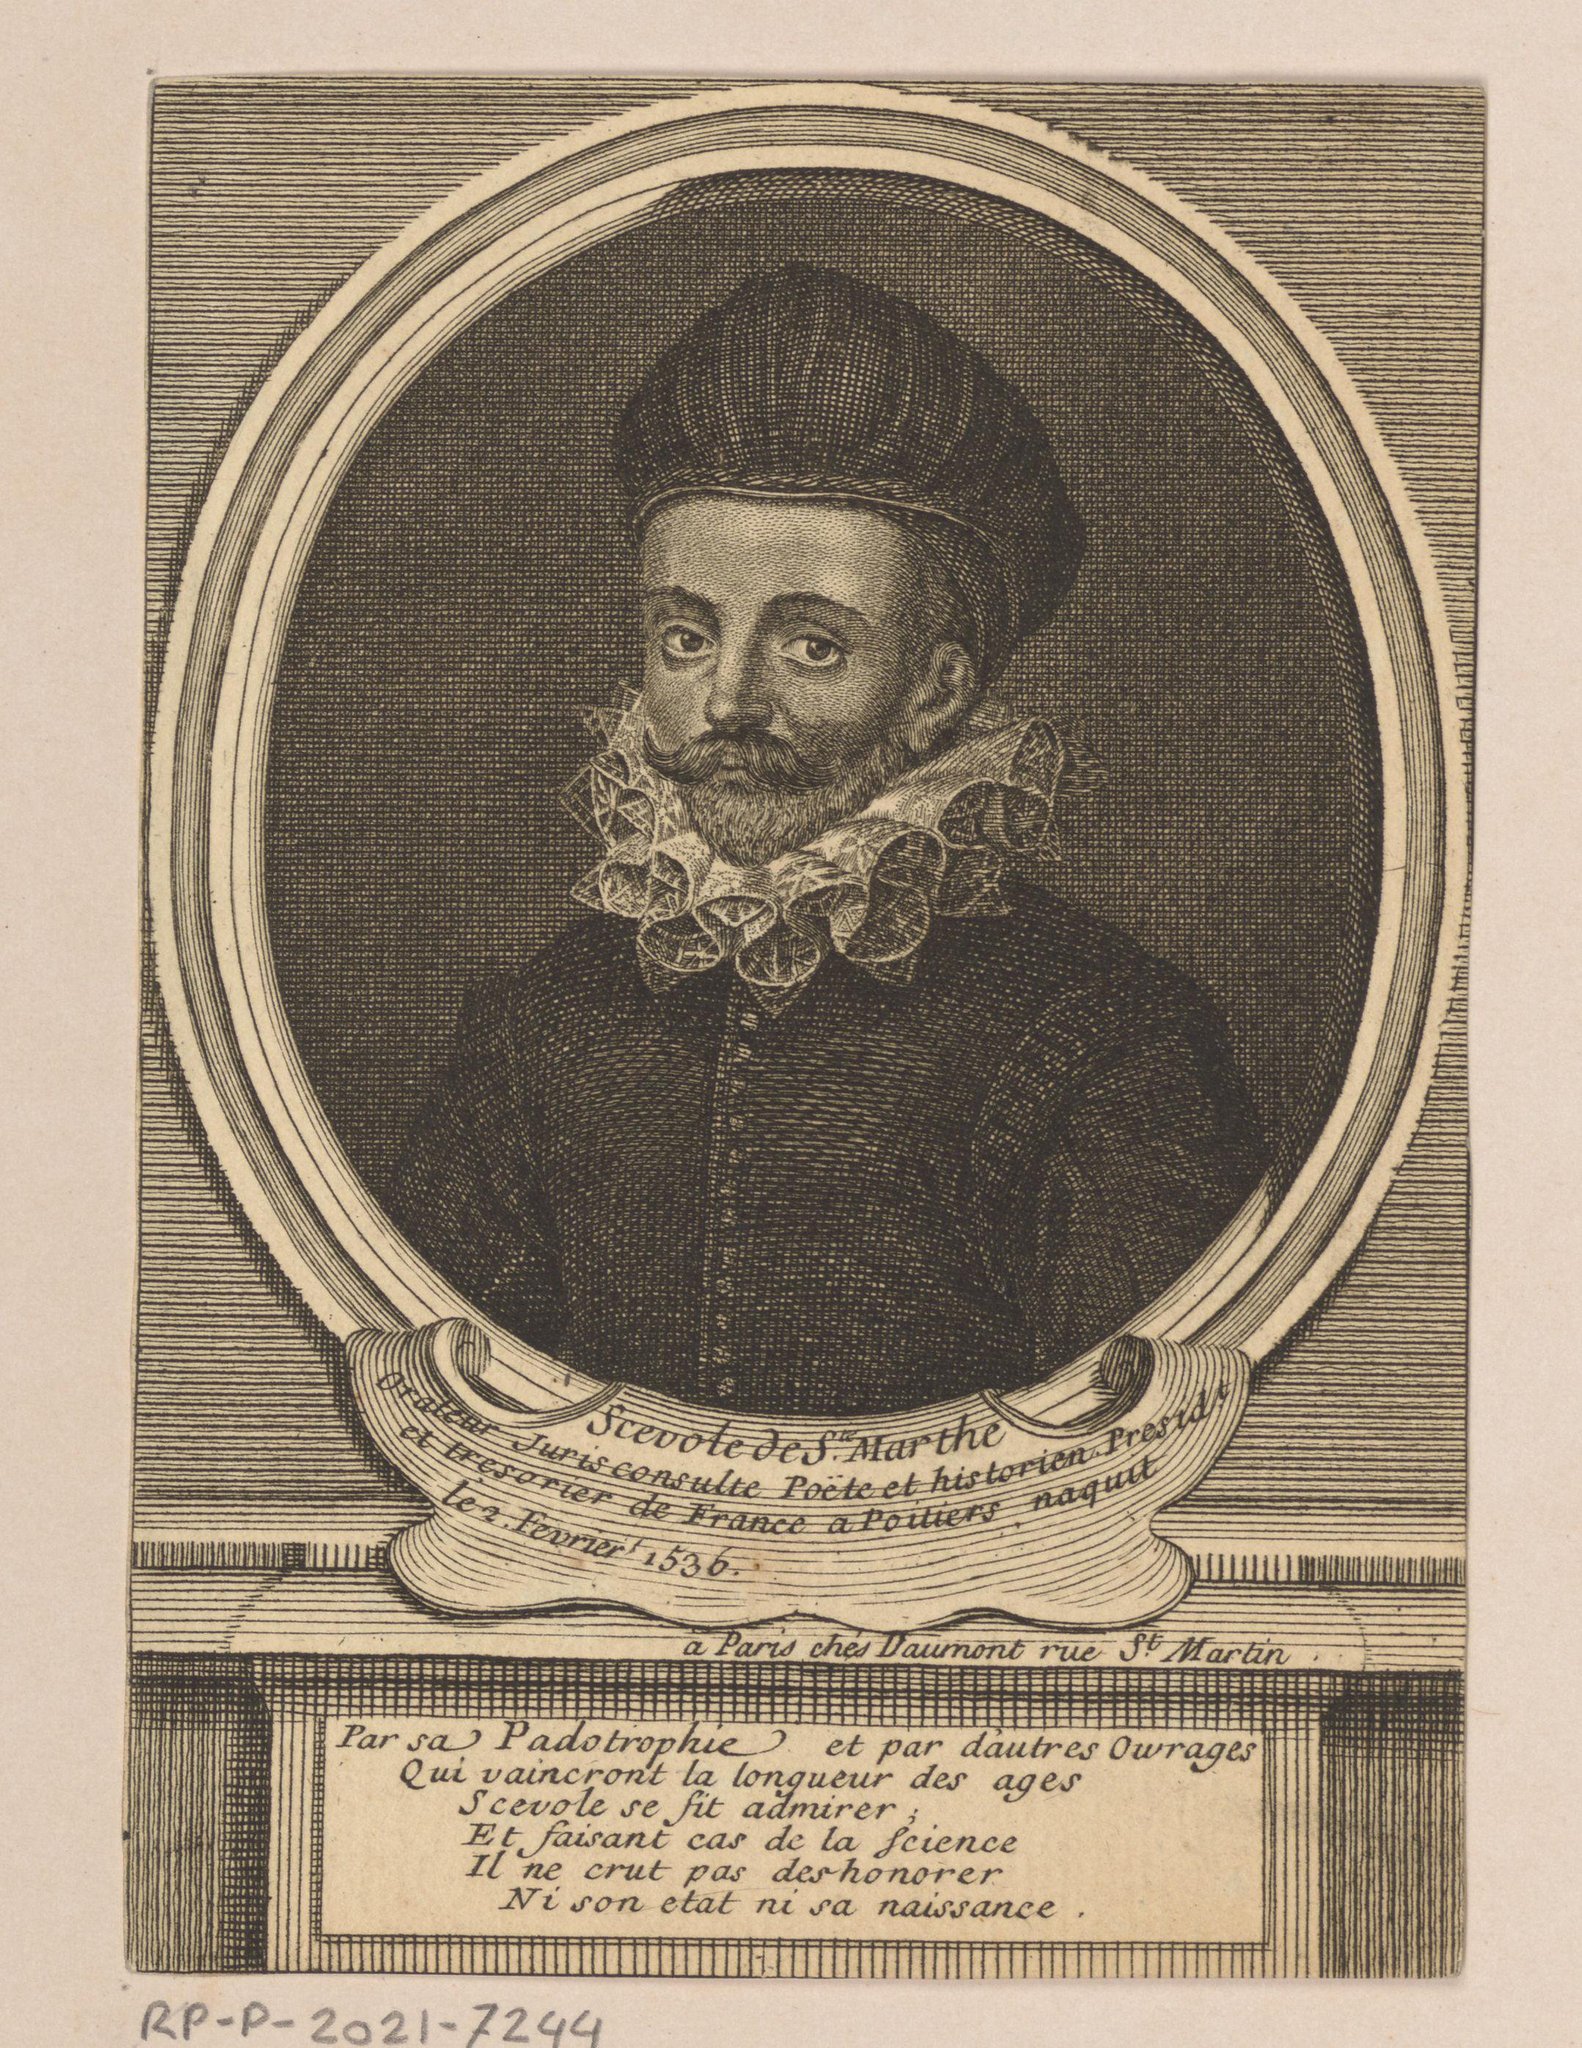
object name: print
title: Portret van Scévole de Sainte-Marthe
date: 1726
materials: paper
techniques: engraving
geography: paris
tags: historical persons, writer, poet, author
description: Latere staat van prent maakt mogelijk deel uit van de serie 'Recueil de portraits de personnes qui se sont distinguées tant dans les Armes (...)', vervaardigd en uitgegeven door Etienne Desrochers. De serie werd initieel uitgegeven door Desrochers en aangekondigd in 'Mercure' in mei 1726, p. 985.